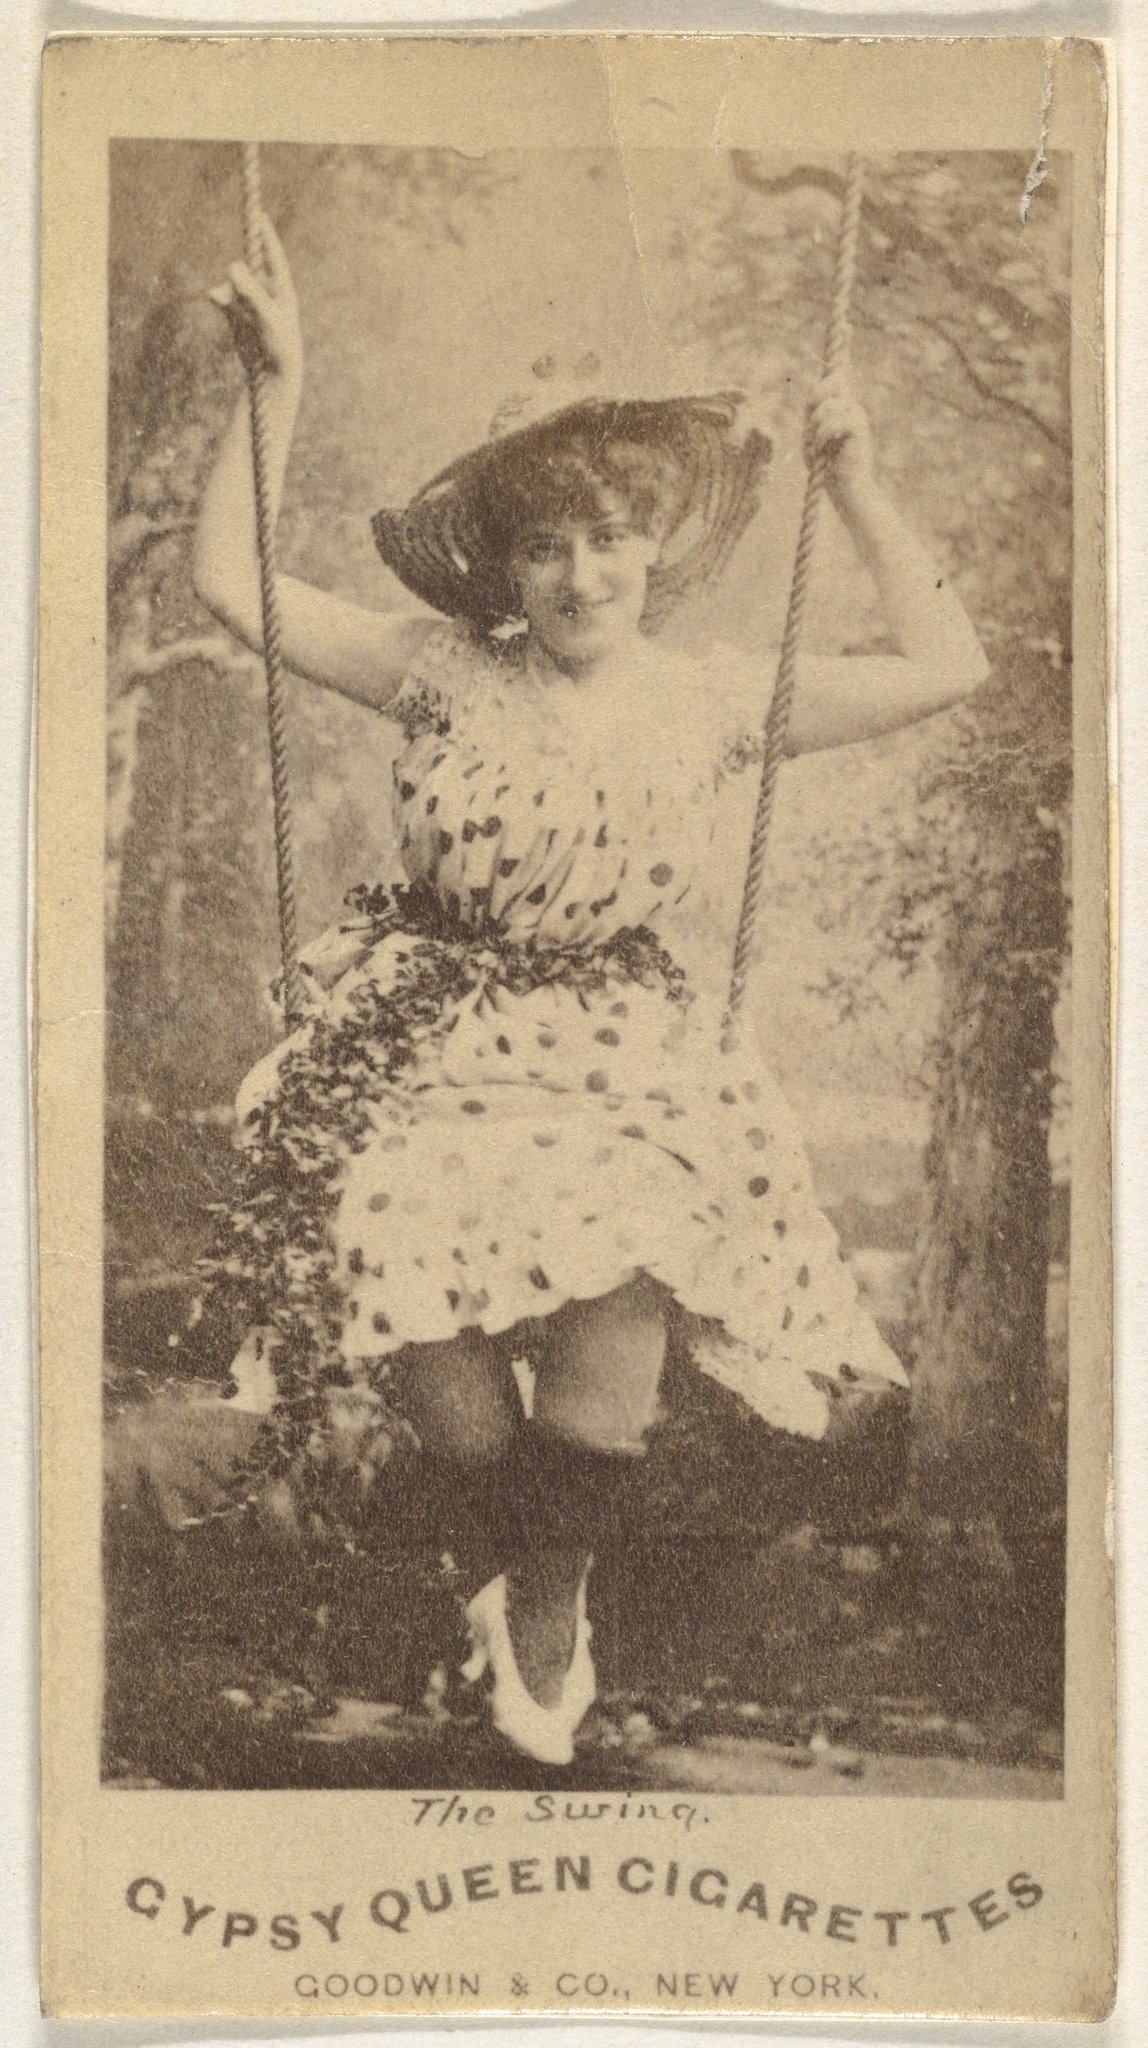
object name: photograph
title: The Swing, from the Actors and Actresses series (N171) for Gypsy Queen Cigarettes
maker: goodwin & company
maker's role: publisher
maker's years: 1850-1950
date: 1886-1890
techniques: albumen silver print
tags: portraits,women,actresses